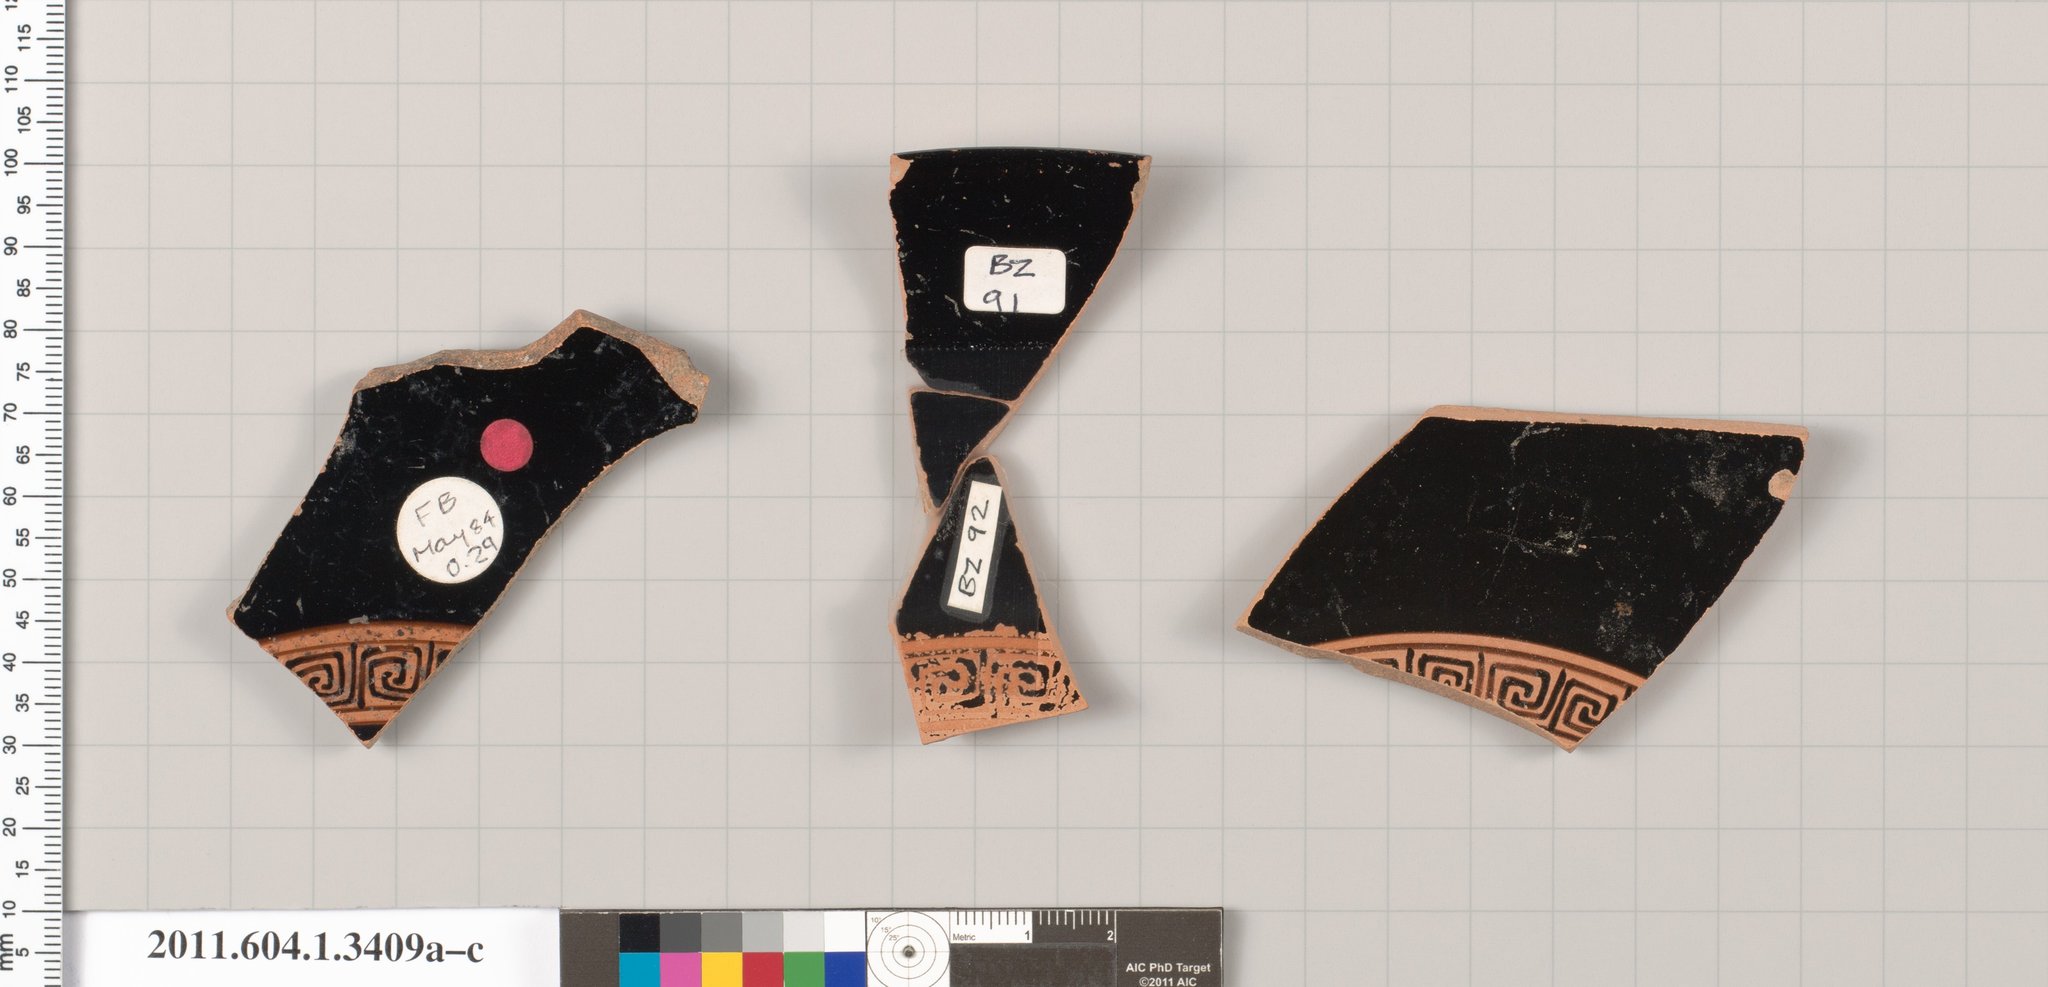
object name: kylix fragment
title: Terracotta fragments of kylikes (drinking cups)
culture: greek, attic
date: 510-470 BCE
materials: terracotta